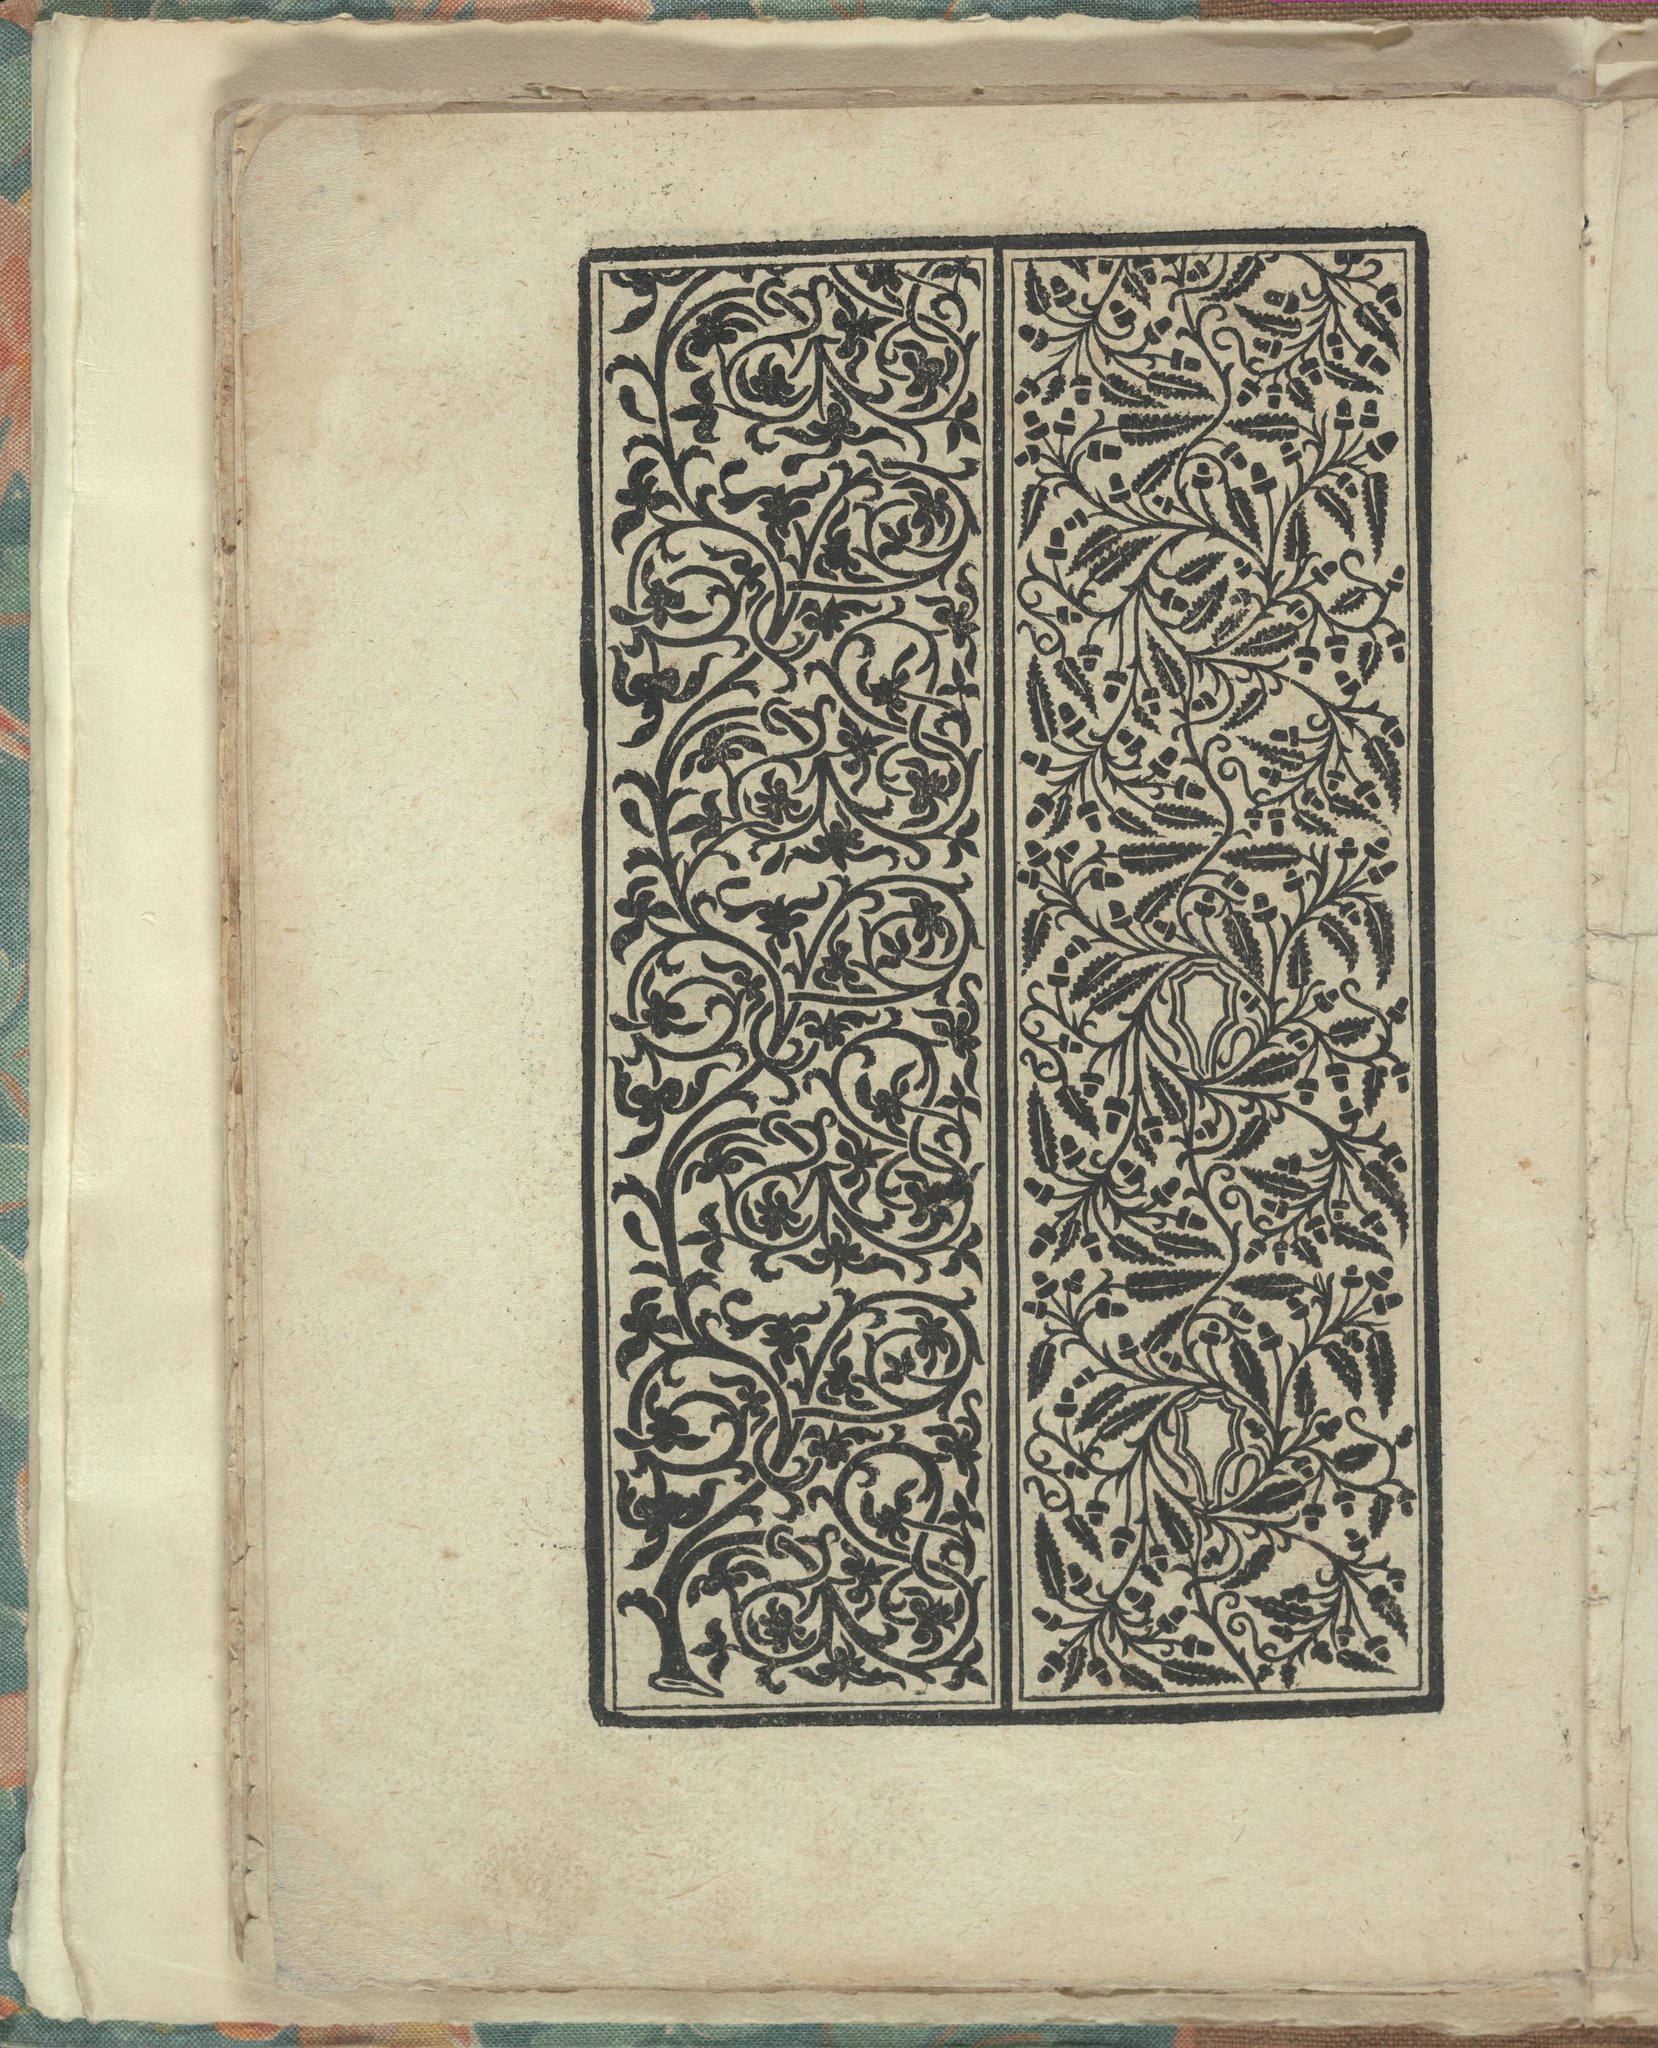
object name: book print ornament architecture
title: Opera Nova Universali intitulata Corona di racammi, page 31 (verso)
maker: giovanni andrea vavassore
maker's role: publisher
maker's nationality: italian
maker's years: 1530-1573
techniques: woodcut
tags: leaves